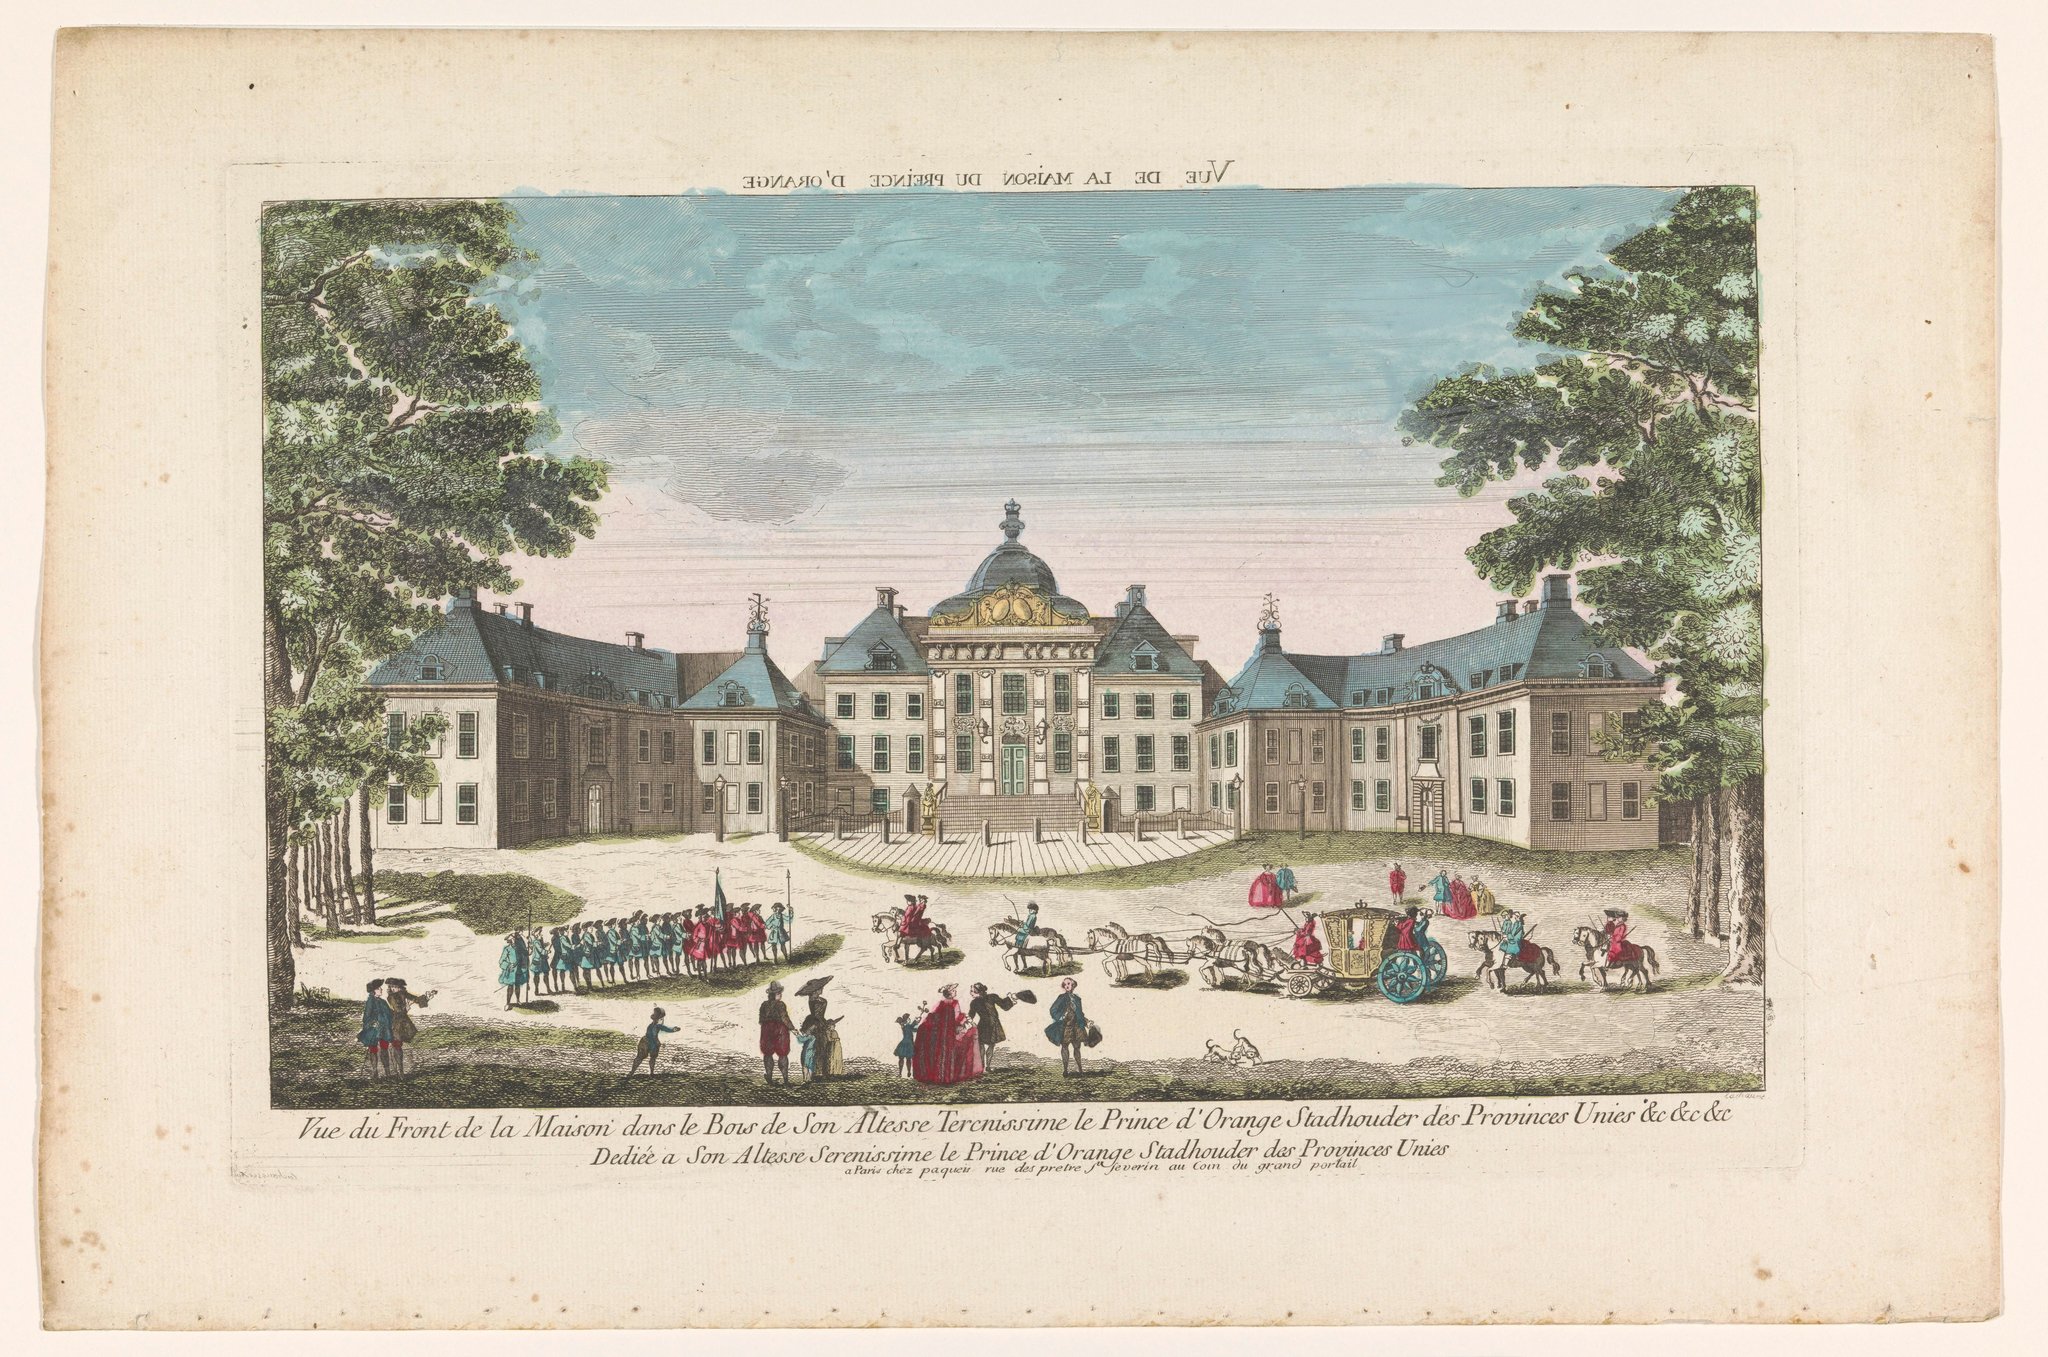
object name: print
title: Gezicht op de voorzijde van het Paleis Huis ten Bosch te Den Haag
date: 1700-1799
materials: paper, watercolor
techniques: brush, etching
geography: france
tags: palace, four-wheeled vehicle drawn by more than three animals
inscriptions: watermark, collector's mark: Lugt 2166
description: Rechts rijdt een koets getrokken door zes paarden.